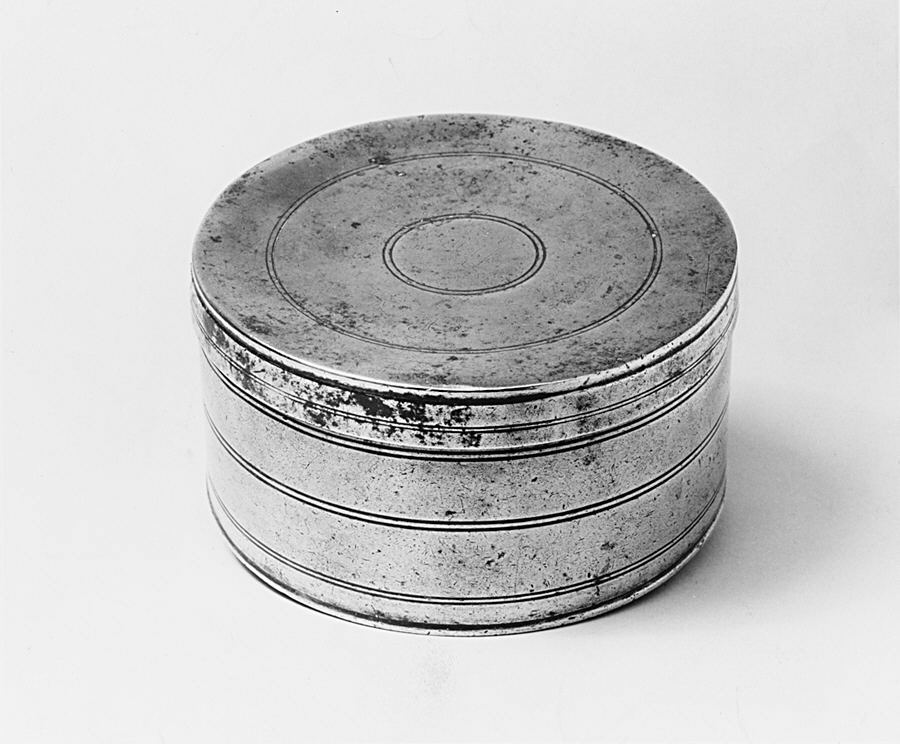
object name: box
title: Covered Box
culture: american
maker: joseph leddel sr.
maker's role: maker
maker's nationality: american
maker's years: 1690-1754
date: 1712-1754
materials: pewter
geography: united states